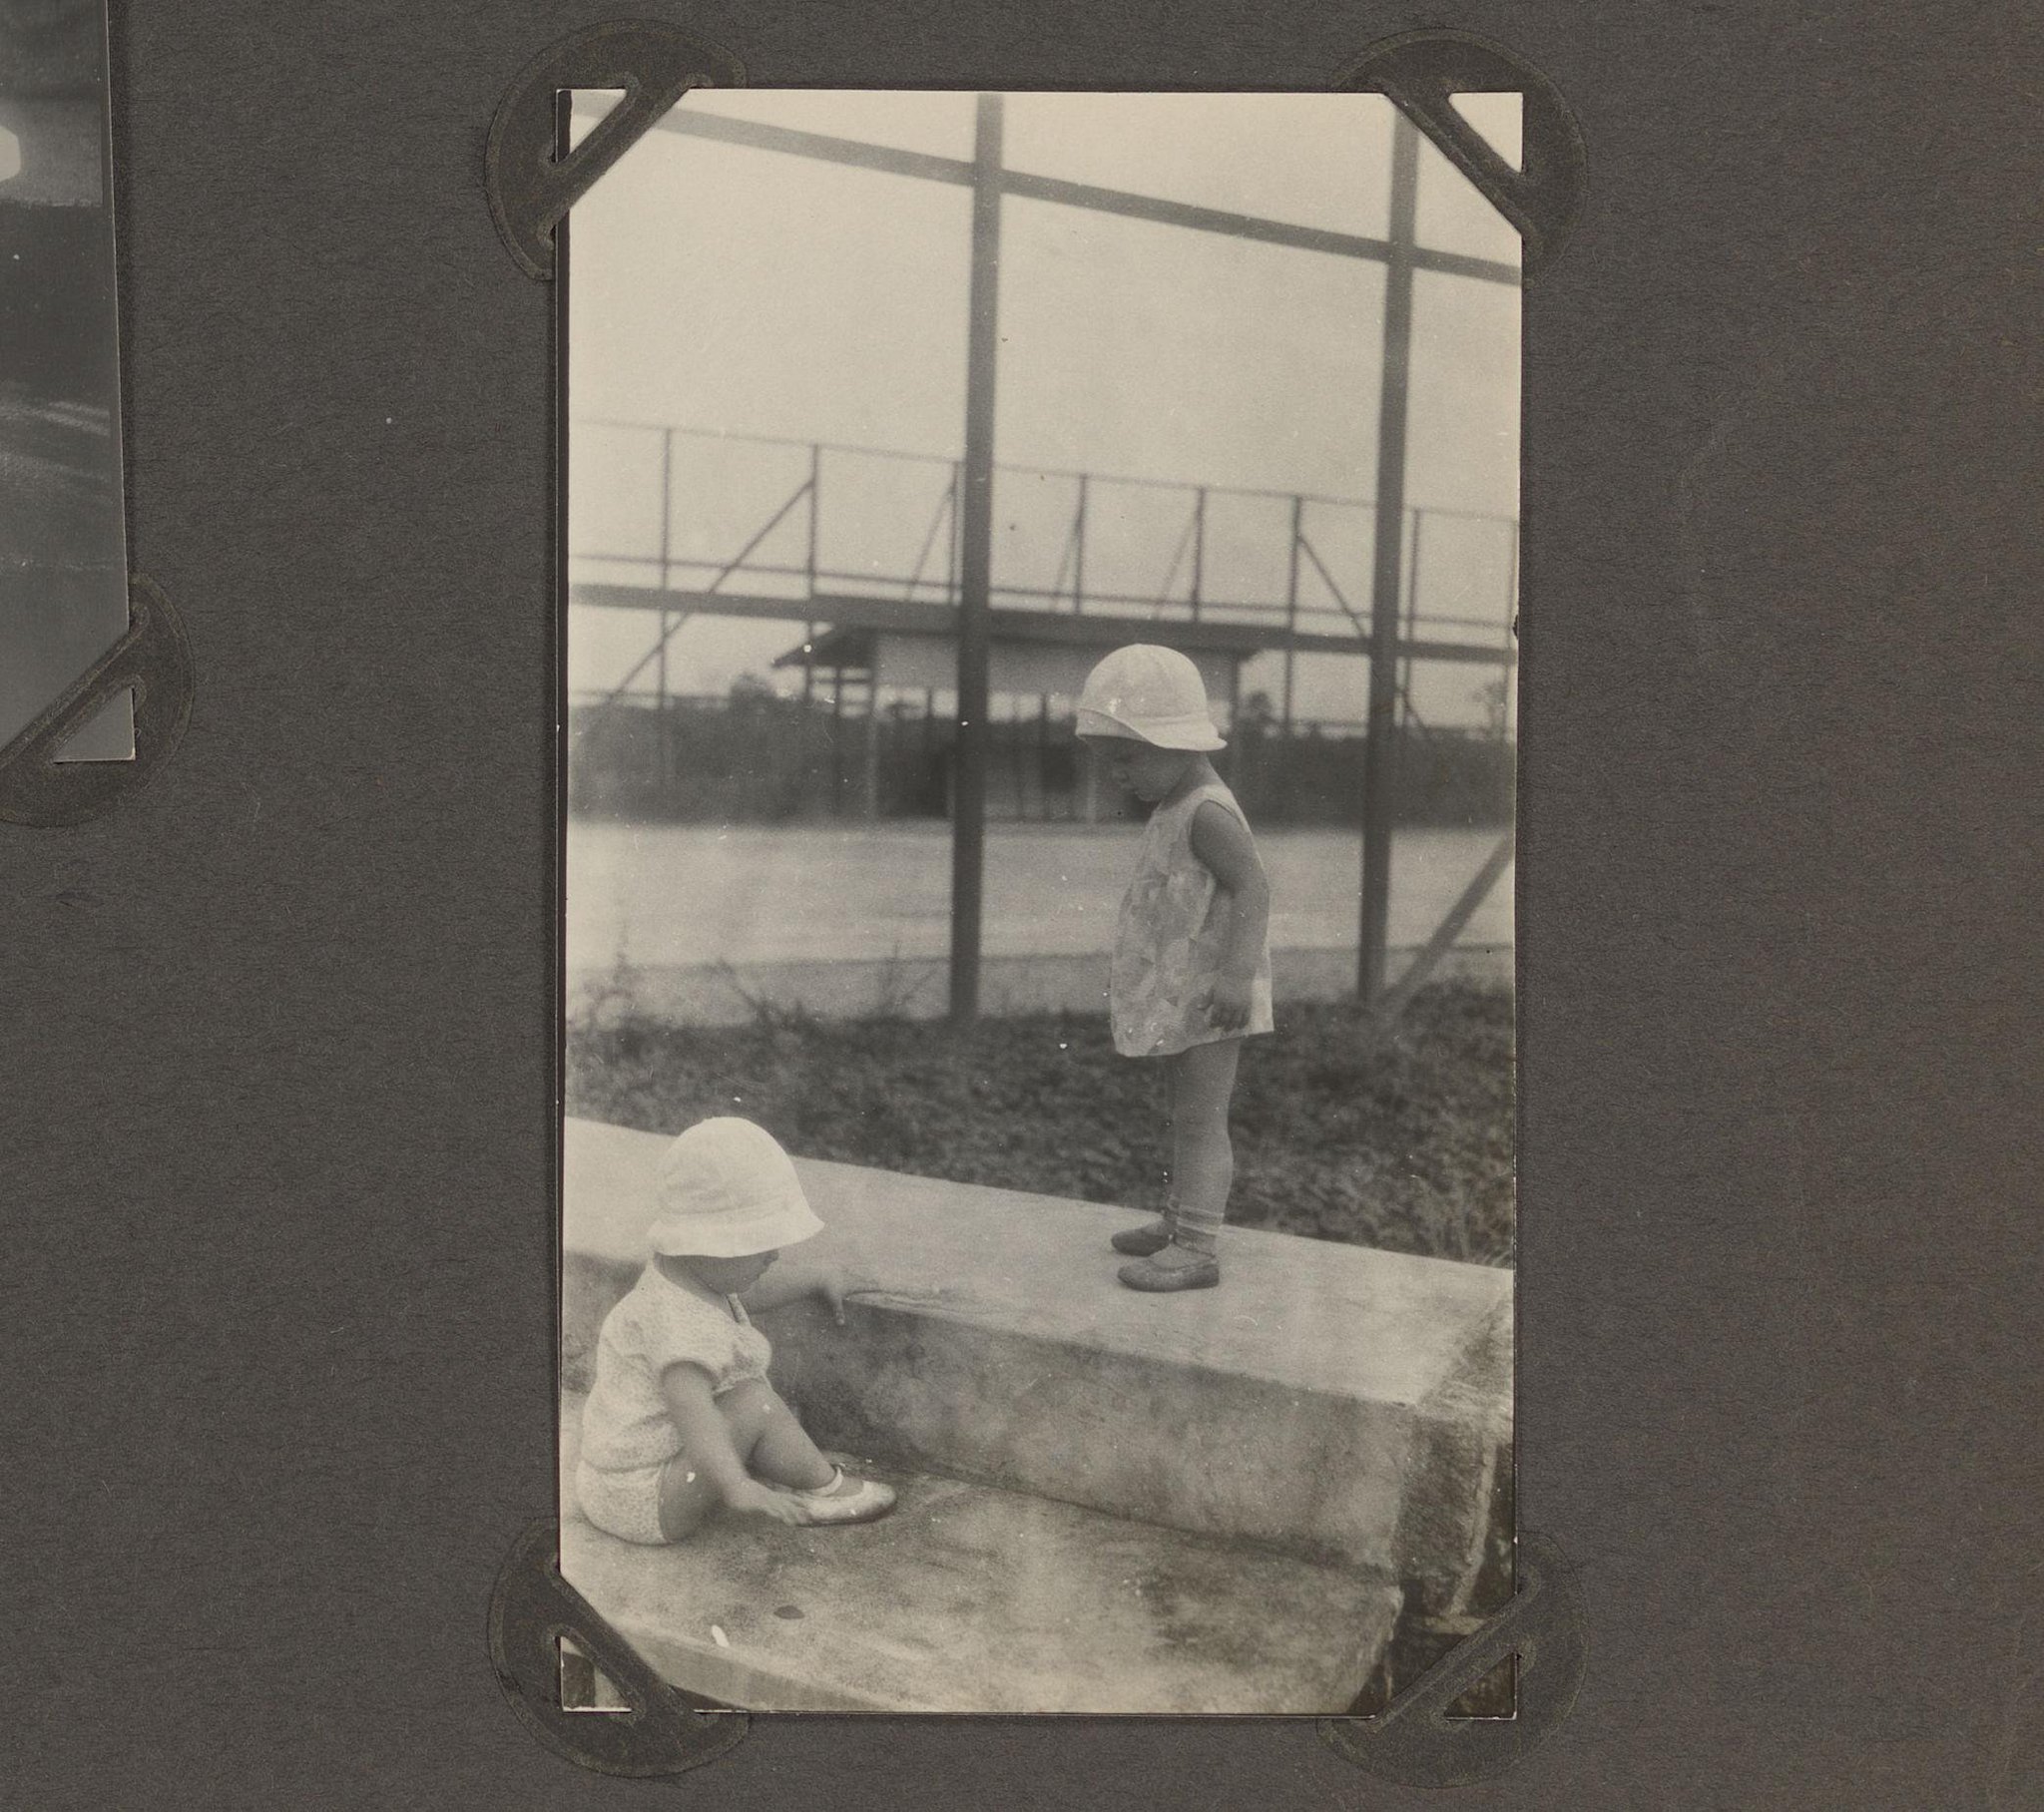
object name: photograph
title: Familiefoto van de kinderen Jetten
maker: Anonymous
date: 1925-1927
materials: photographic support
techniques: photography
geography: suriname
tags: jetten, familie, moengo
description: Familiefoto van de kinderen Jetten. Foto op een bladzijde van een los albumblad. Onderdeel van het ensemble met foto's van de familie van ingenieur Jetten in de mijnbouwstad Moengo in Suriname.